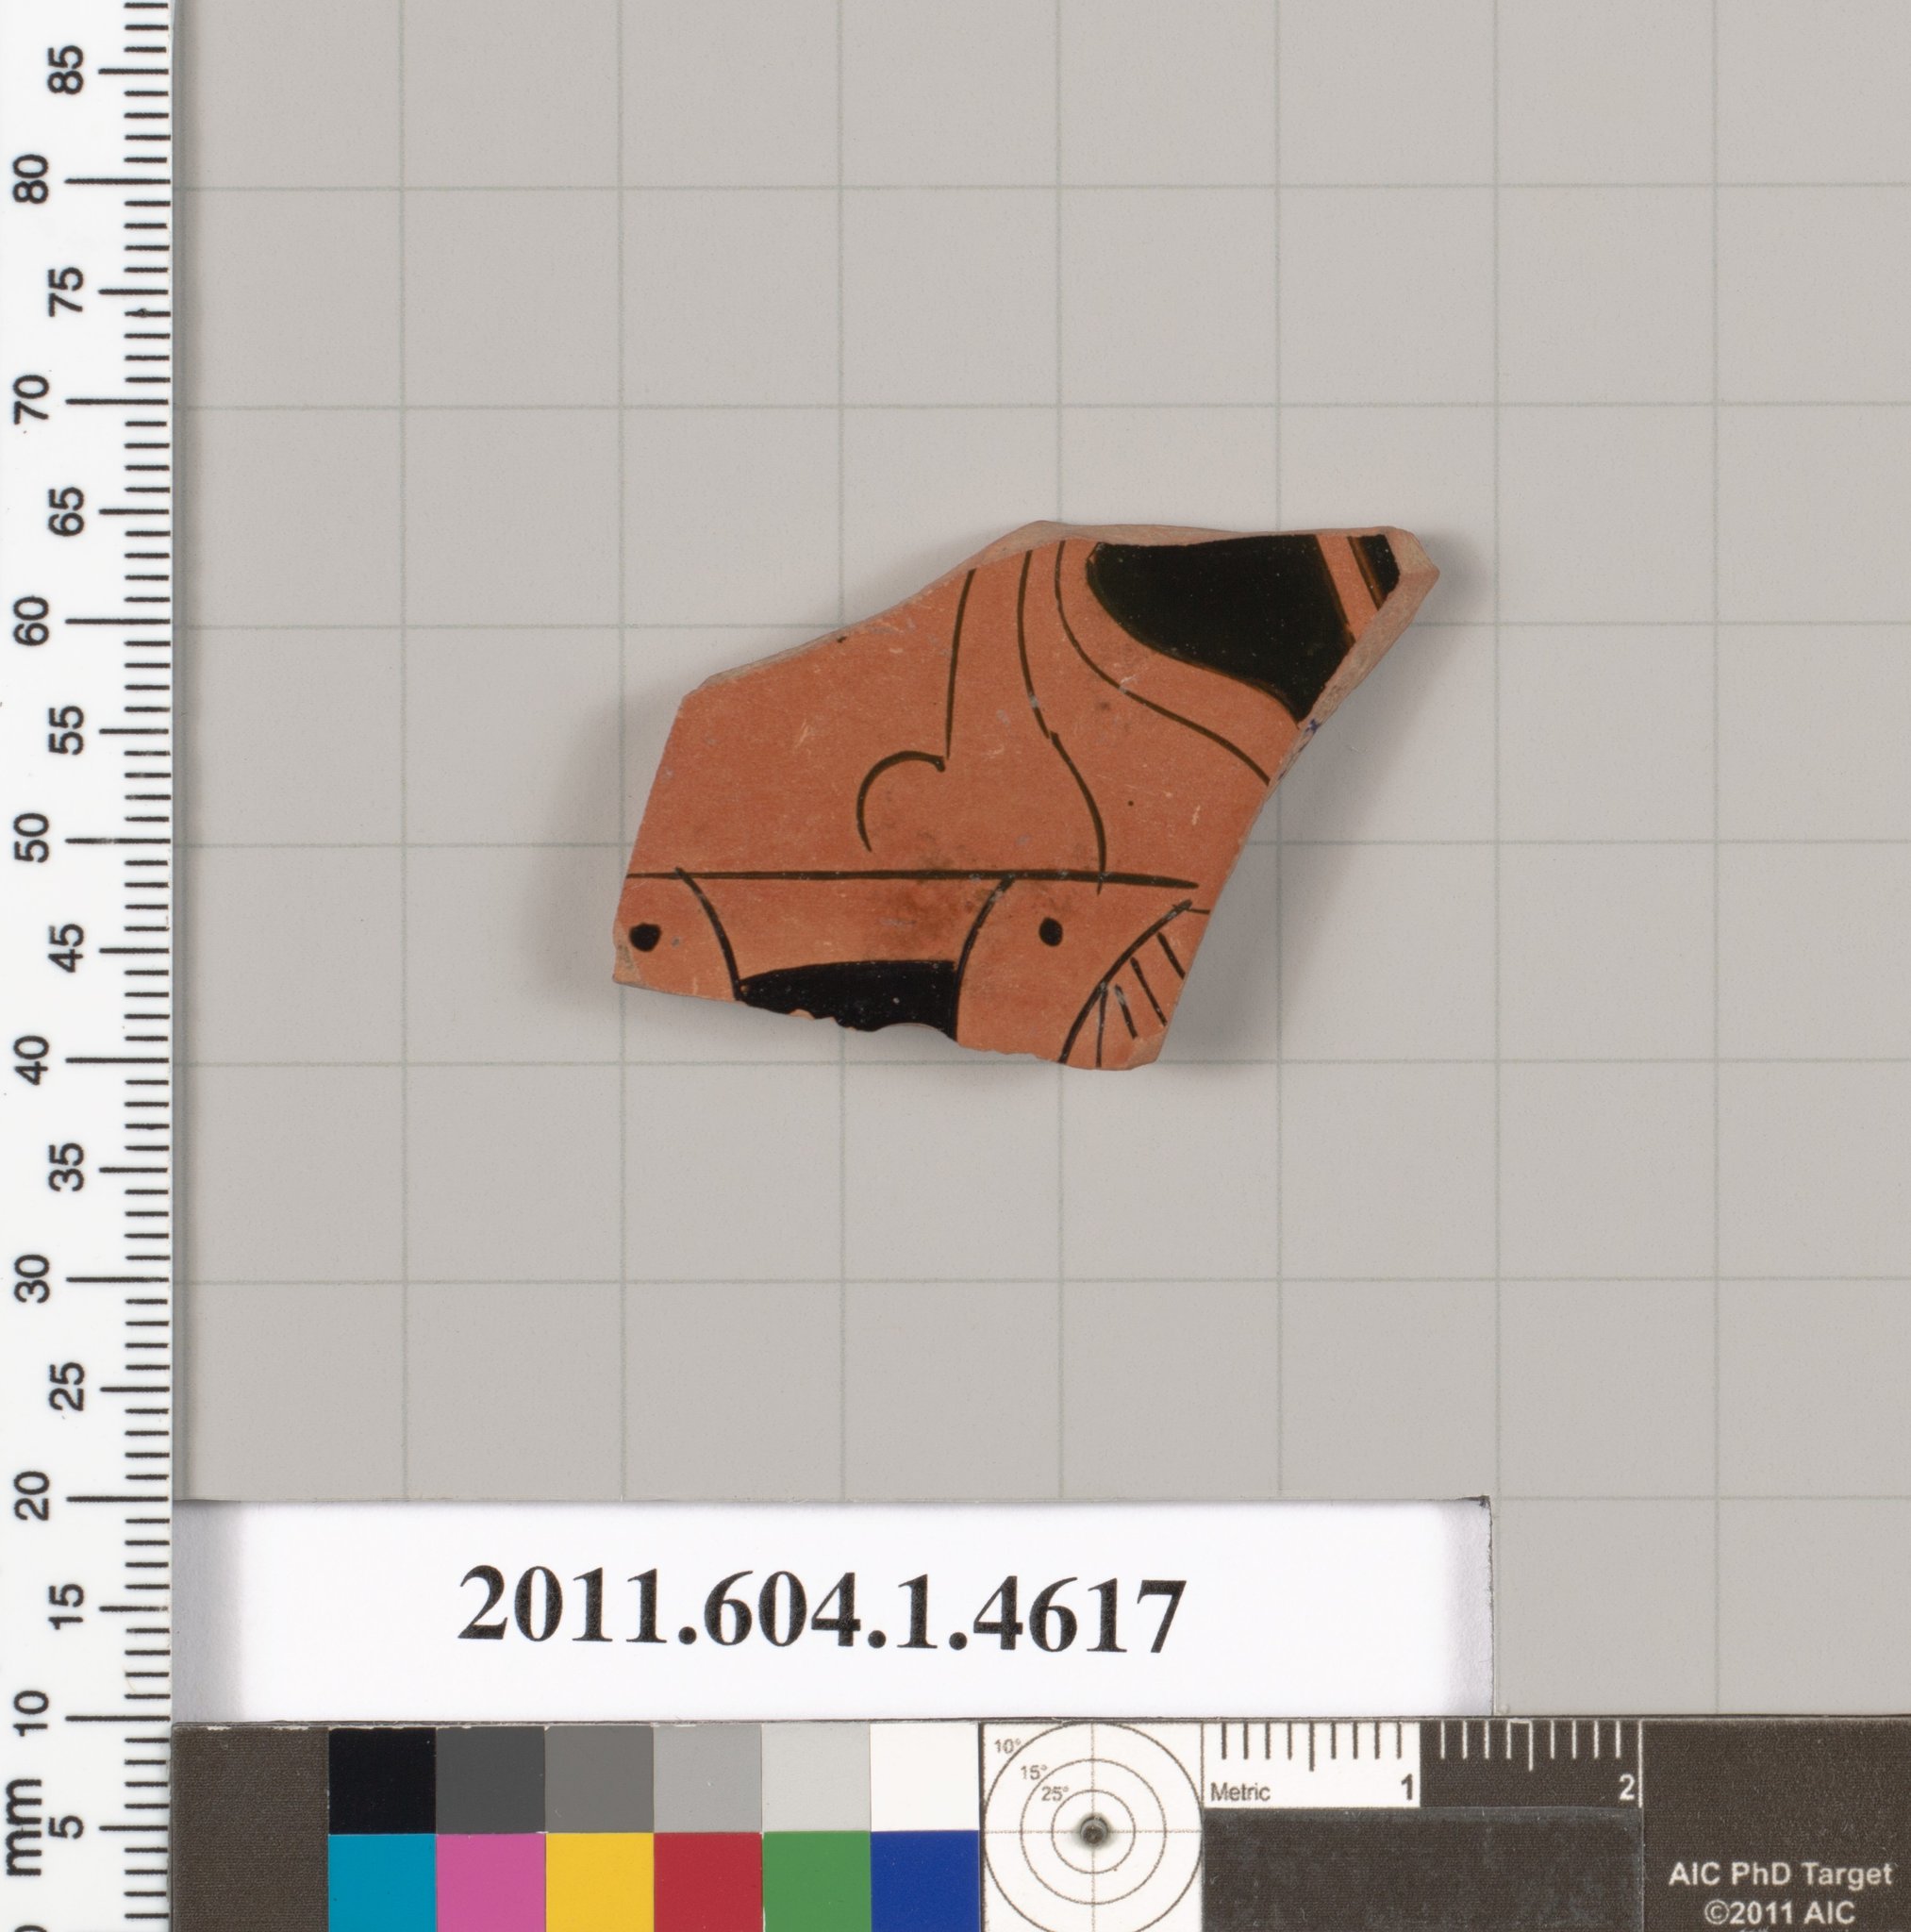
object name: kylix fragment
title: Terracotta fragment of a kylix (drinking cup)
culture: greek, attic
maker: makron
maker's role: artist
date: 500-480 BCE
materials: terracotta